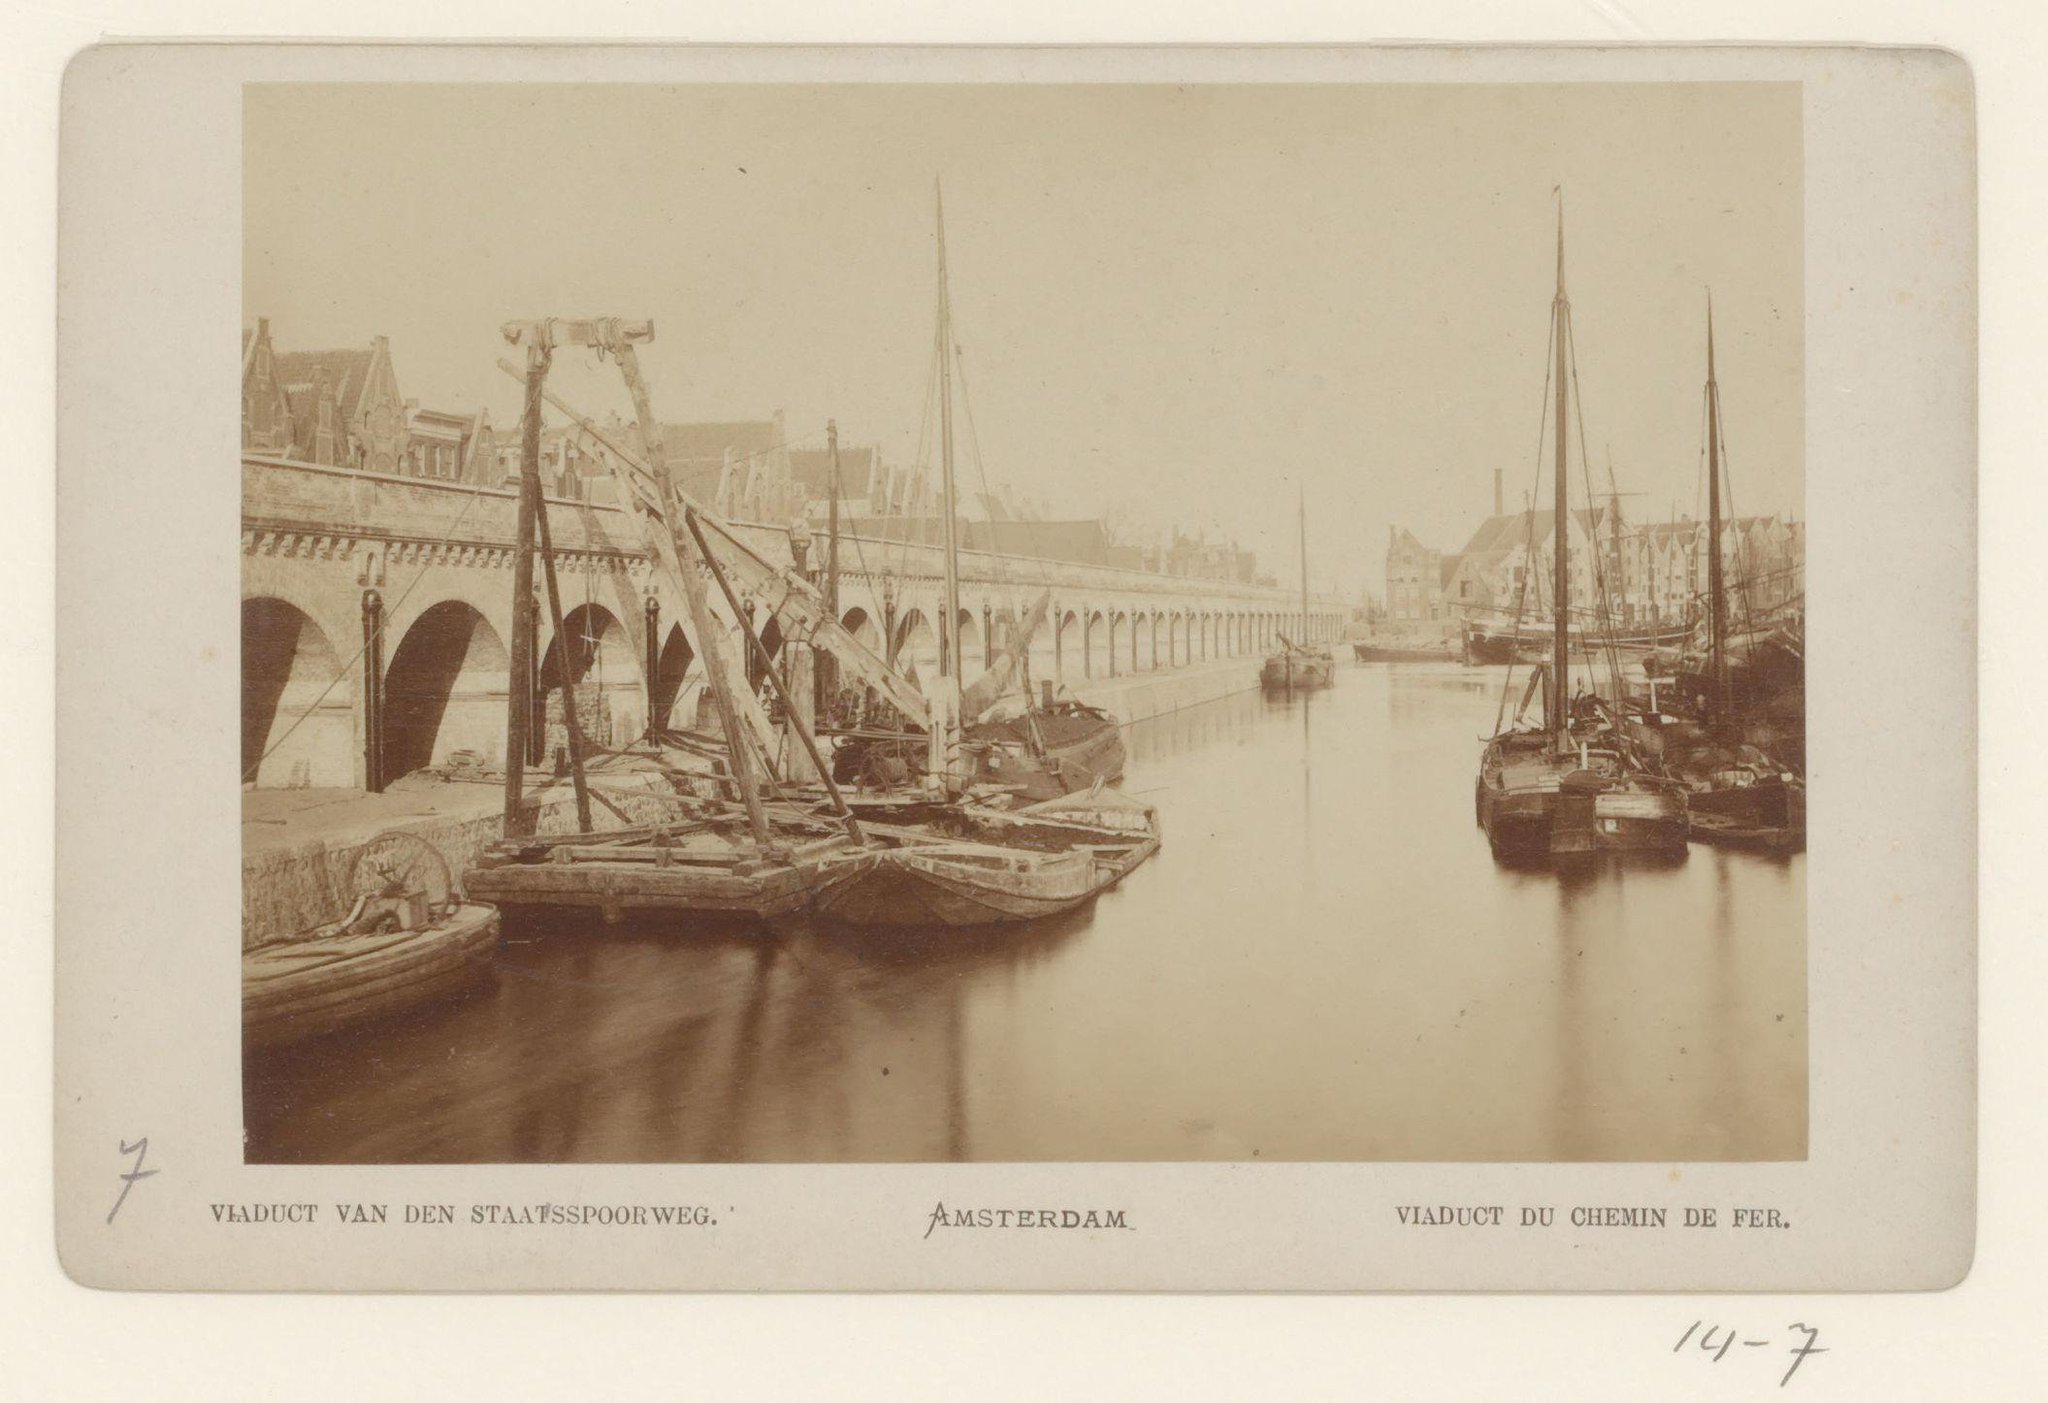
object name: cabinet photograph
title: Gezicht op het viaduct bij Station Amsterdam Centraal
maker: Anonymous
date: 1850-1915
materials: cardboard, paper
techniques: albumen print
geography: amsterdam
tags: viaduct, sailing-ship, sailing-boat, city-view in general; 'veduta', railway, train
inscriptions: collector's mark: ‘14.7’ Lugt 1641b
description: Onderwerpsrubriek binnen de Atlas Amsterdam: Verhulststraat (Johannes), Viaducten, Vierwindenstraat, Vinkenbuurt, Vinkenpad, Vinkenstraat, Vischsteeg, Vliegendesteeg, Voetboogstraat, Volewijk, Vondelstraat, Voorburgwal (N.Z.).